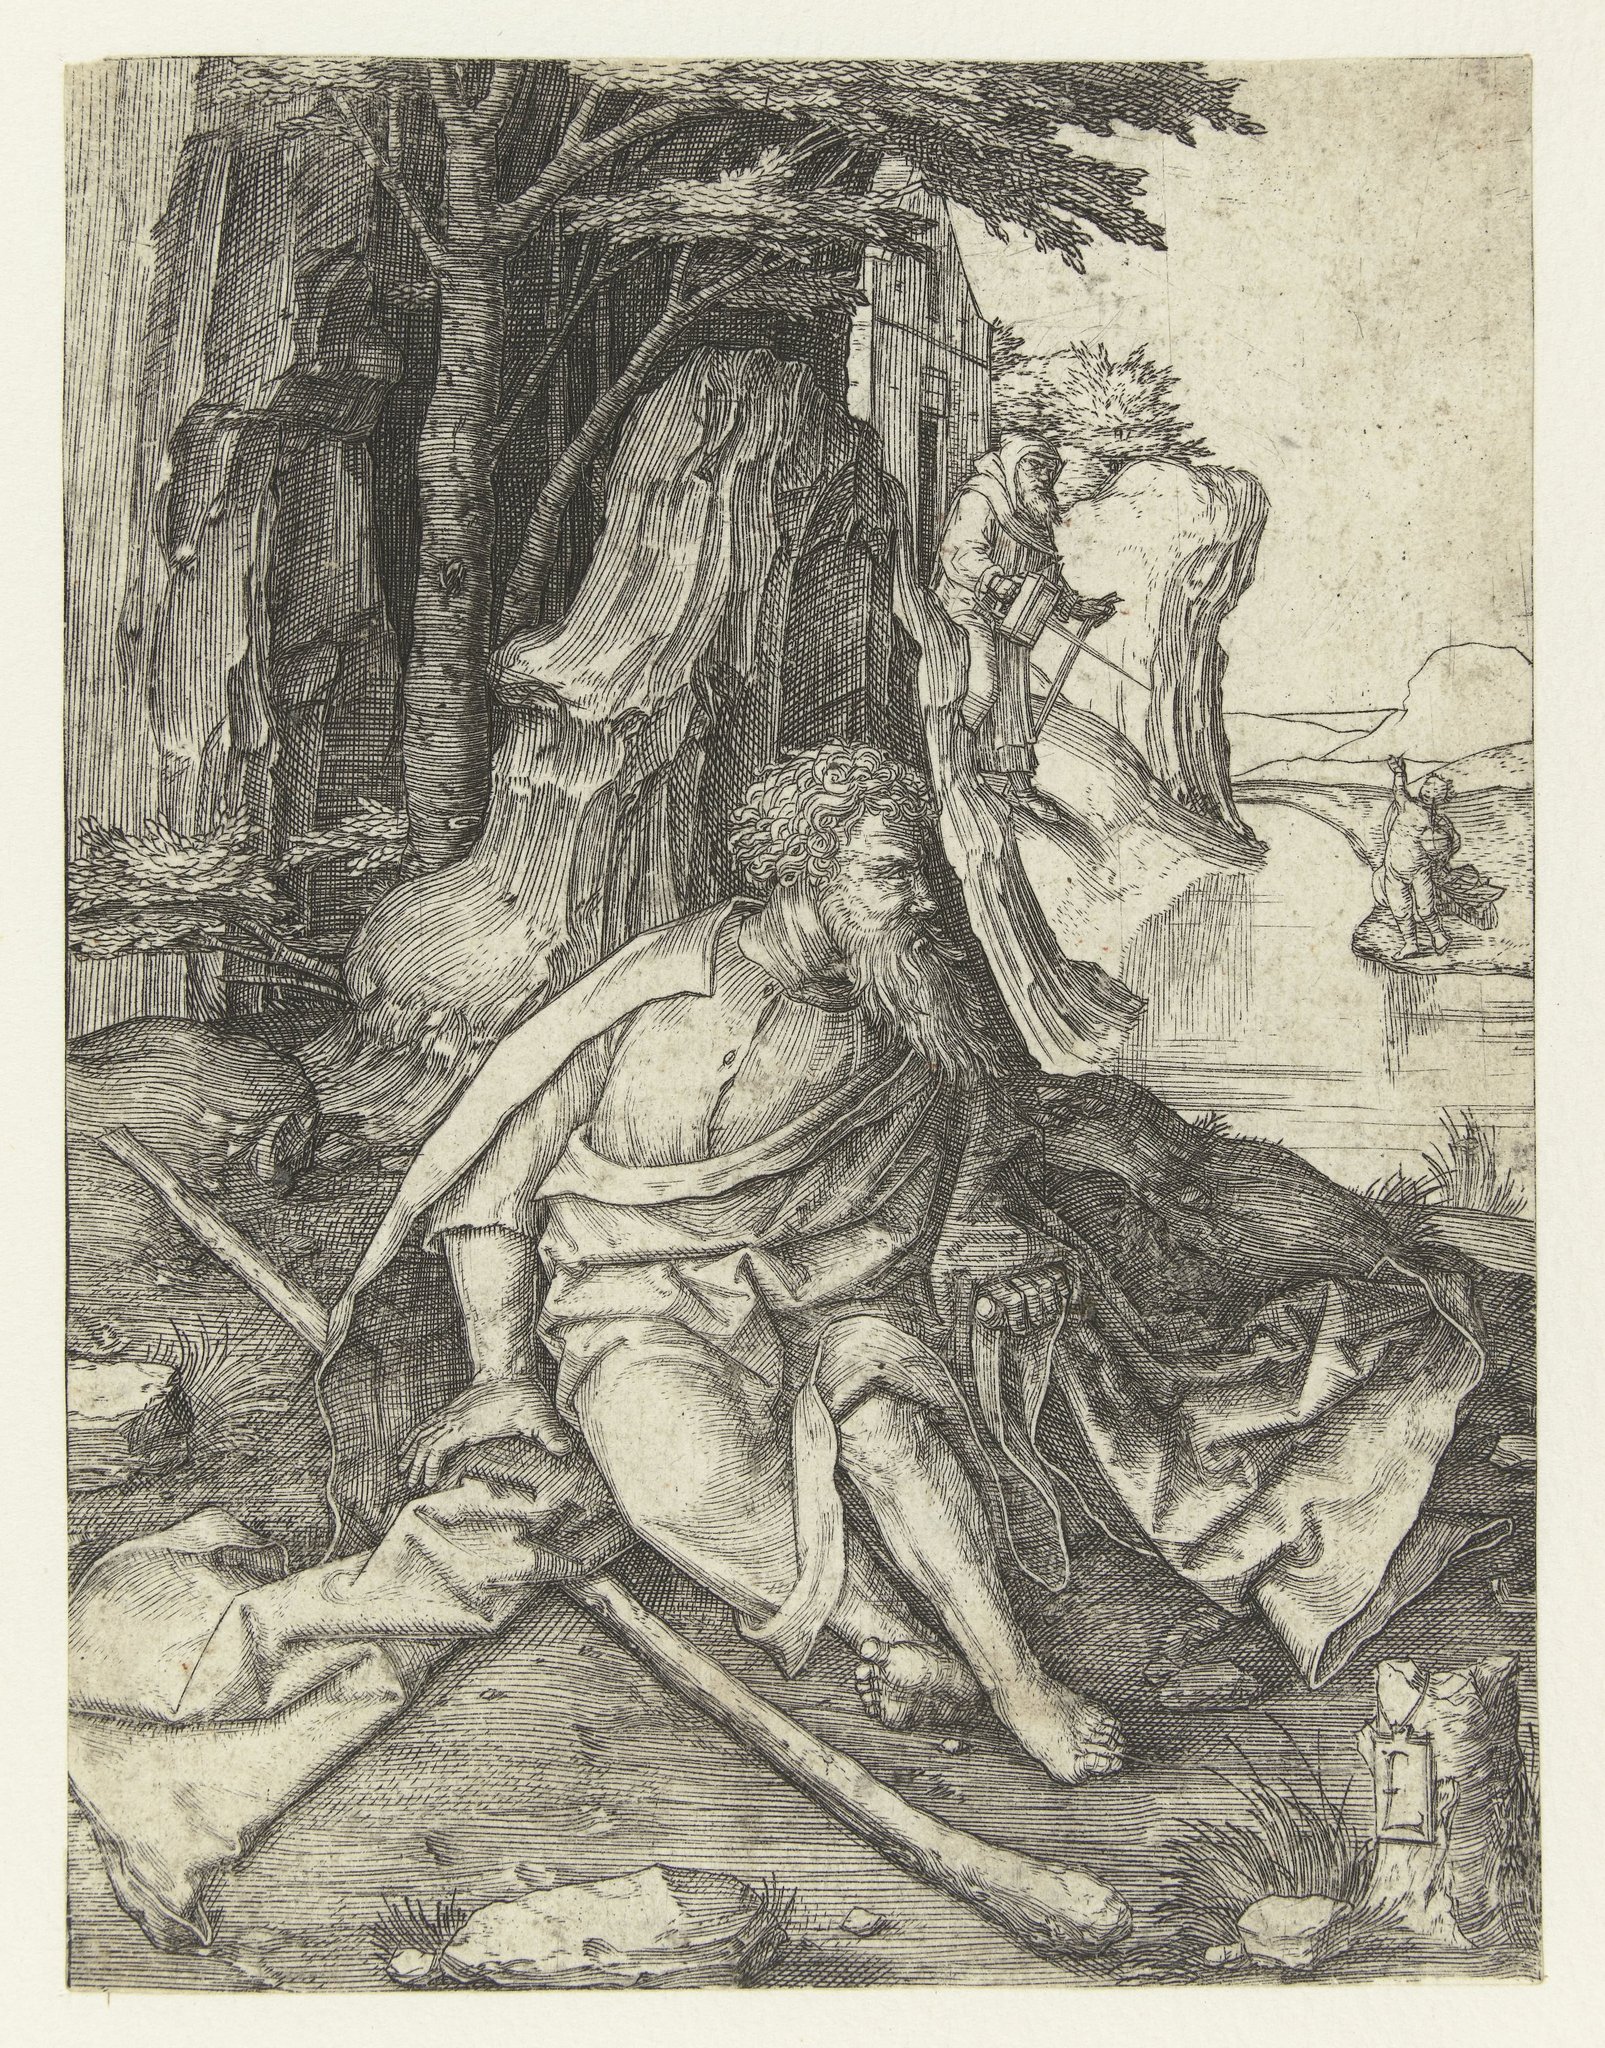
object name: print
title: Heilige Christoffel aan de oever van een rivier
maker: lucas van leyden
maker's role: draughtsman, painter, print maker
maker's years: 1494-1533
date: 1504-1508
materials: paper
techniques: engraving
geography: low countries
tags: st. christopher, with the infant christ on his shoulders, wading through the water and carrying his staff (palm-tree); sometimes a hermit stands on the further bank beside a chapel, a lantern in his hand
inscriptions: collector's mark: Lugt 2228a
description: Christoffel met staf zittend aan de oever van de rivier. Rechts op de achtergrond de kluizenaar staand bij het water met een lantaarn, aan de overzijde het Christuskind.